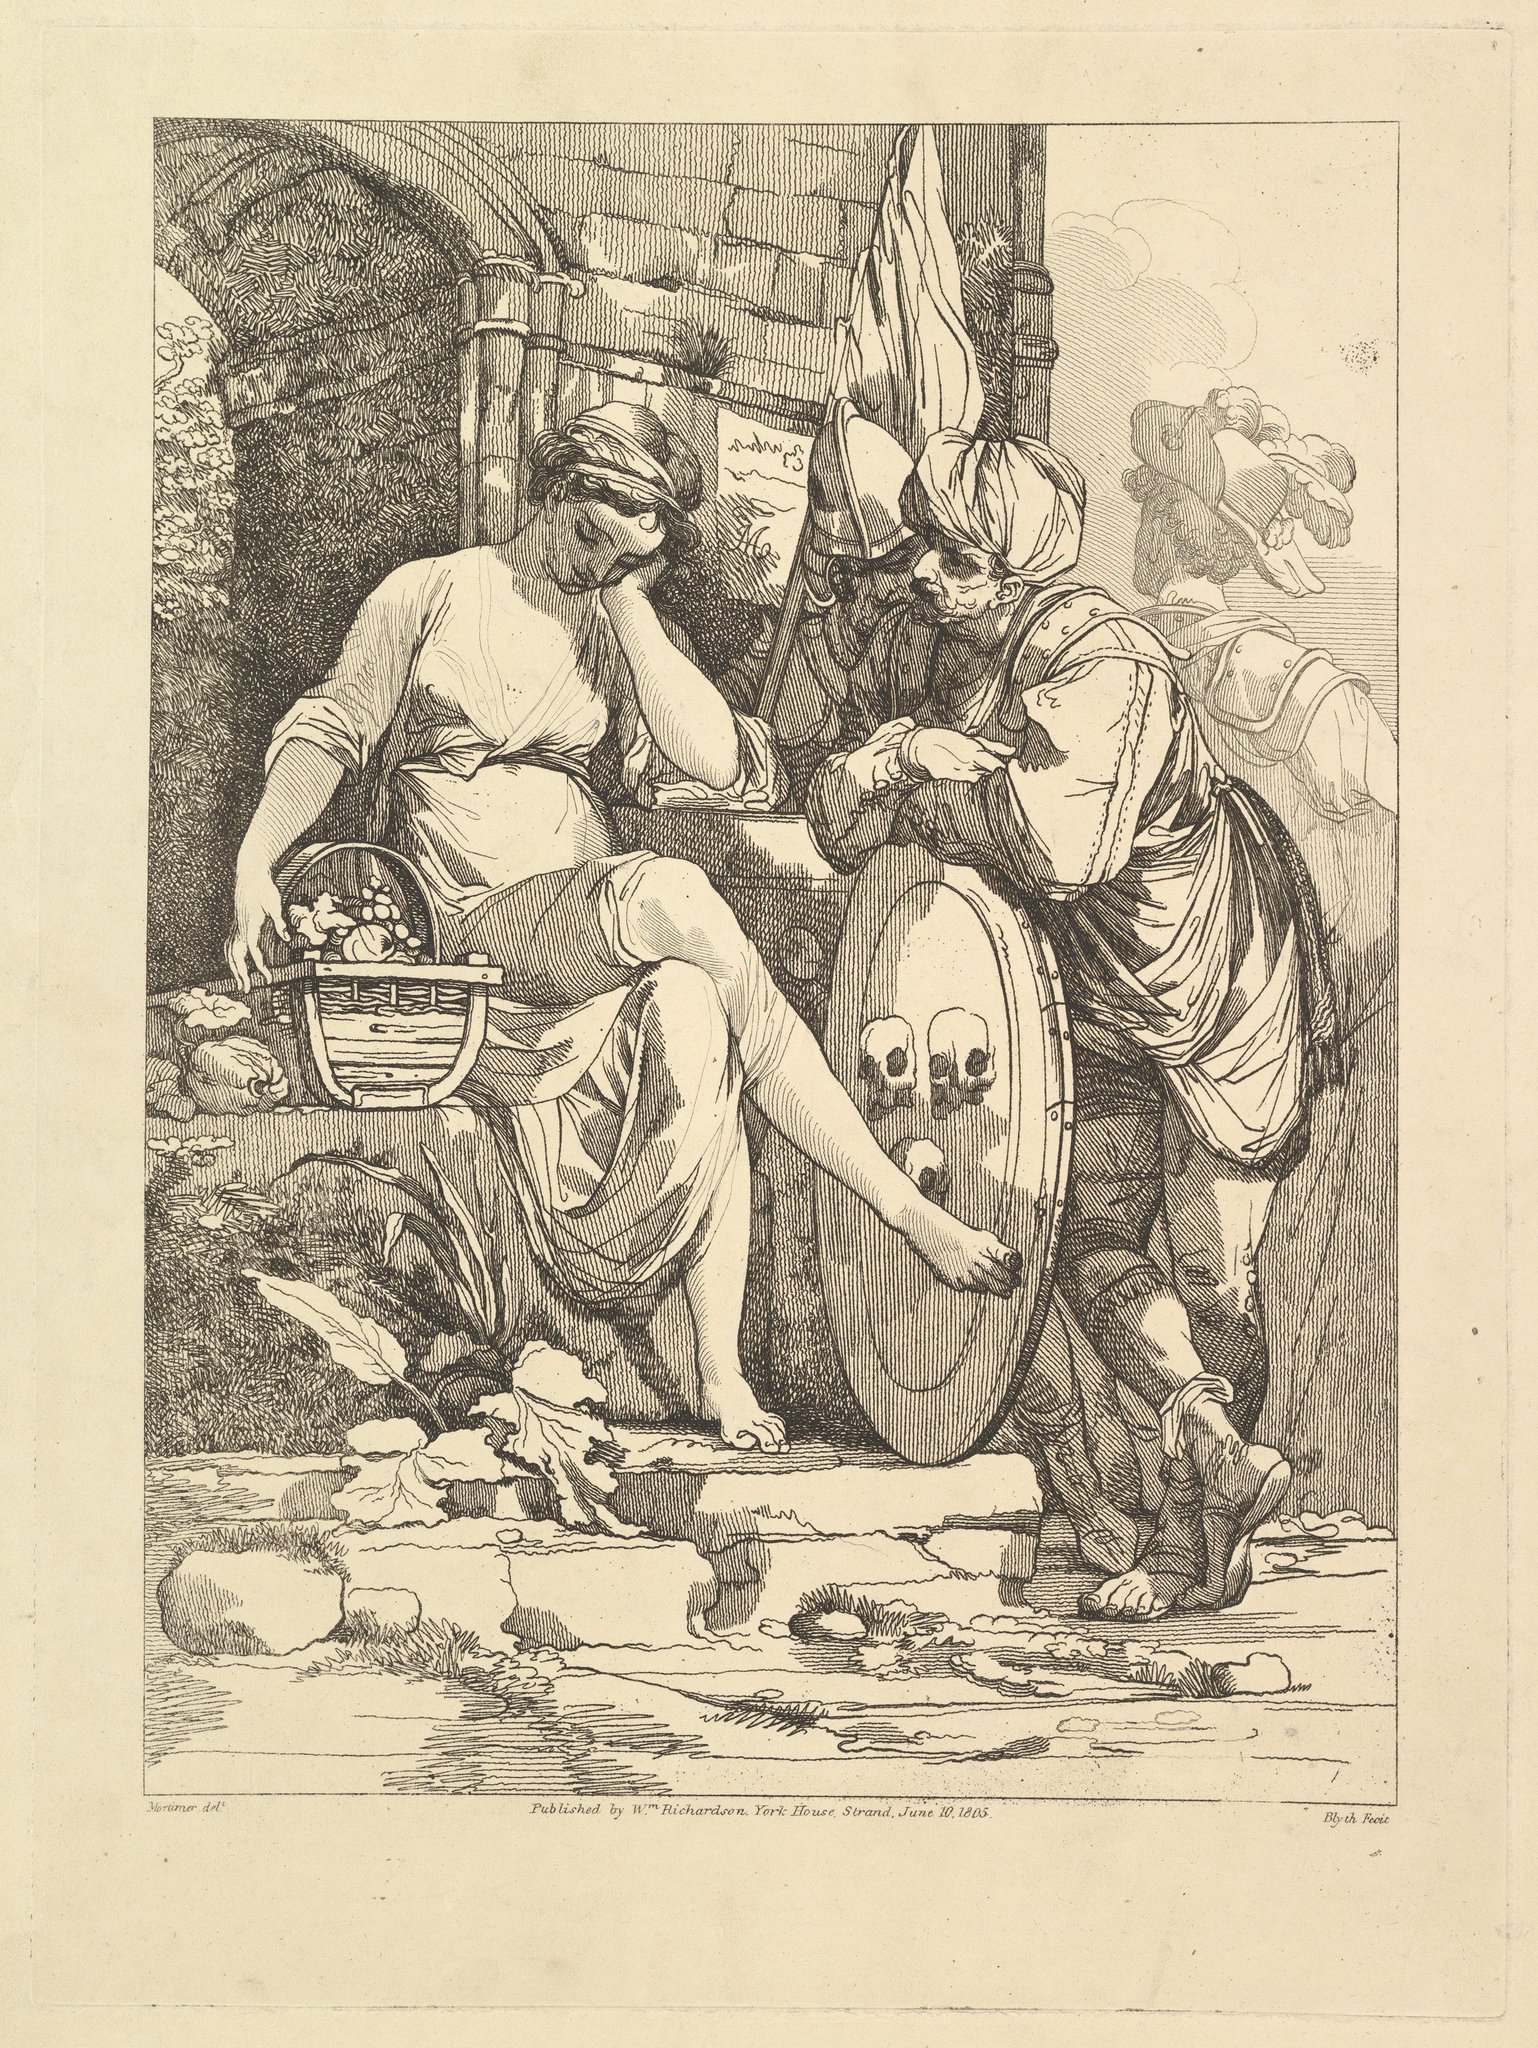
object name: print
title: Banditti at Market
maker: robert blyth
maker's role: artist and publisher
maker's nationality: british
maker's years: 1750-1784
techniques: etching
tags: men,women